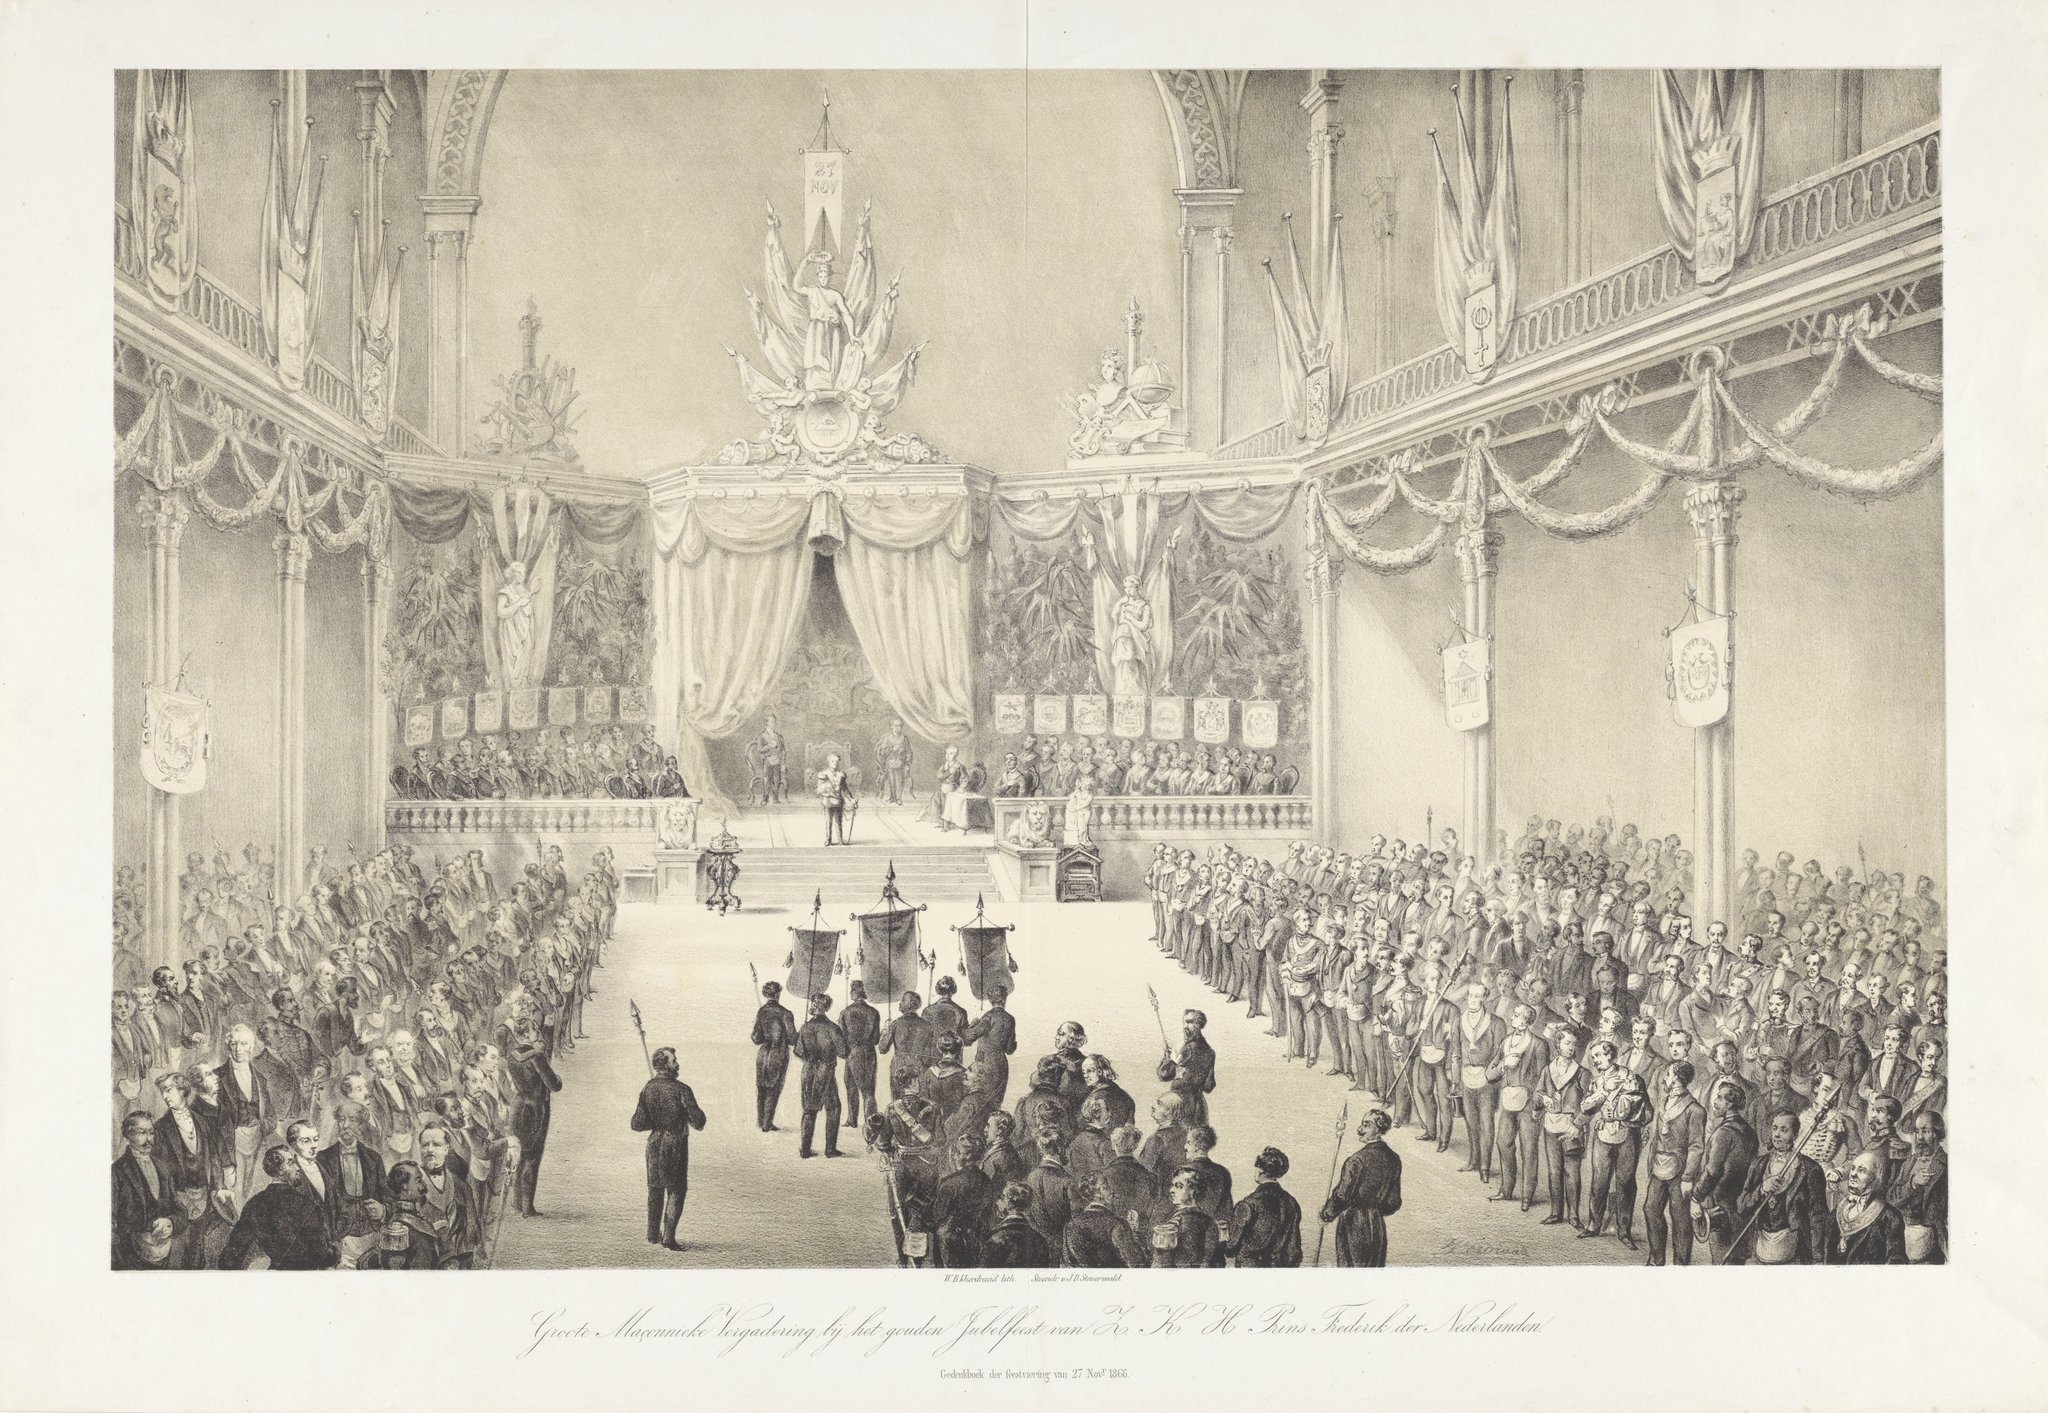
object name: print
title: Groote Maçonnieke Vergadering bij het gouden Jubelfeest van Z.K.H. Prins Frederik der Nederlanden. Gedenkboek der feestviering van 27 Nov.r 1866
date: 1866-1867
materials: paper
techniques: tone lithography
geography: netherlands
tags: berlin, frederik (prins der nederlanden), miscellaneous religions, cults and doctrines: freemasonry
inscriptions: collector's mark: Lugt 2228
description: Grote vergadering van de vrijmetselarij ter gelegenheid van het het gouden jubileum van Prins Frederik als Grootmeester Nationaal der Orde van Vrijmetselaren, 27 november 1866. Gezicht in een grote zaal met centraal Prins Frederik staande op een podium, links en rechts andere vrijmetselaren, centraal komt een afvaardiging met vaandels de zaal ingelopen.